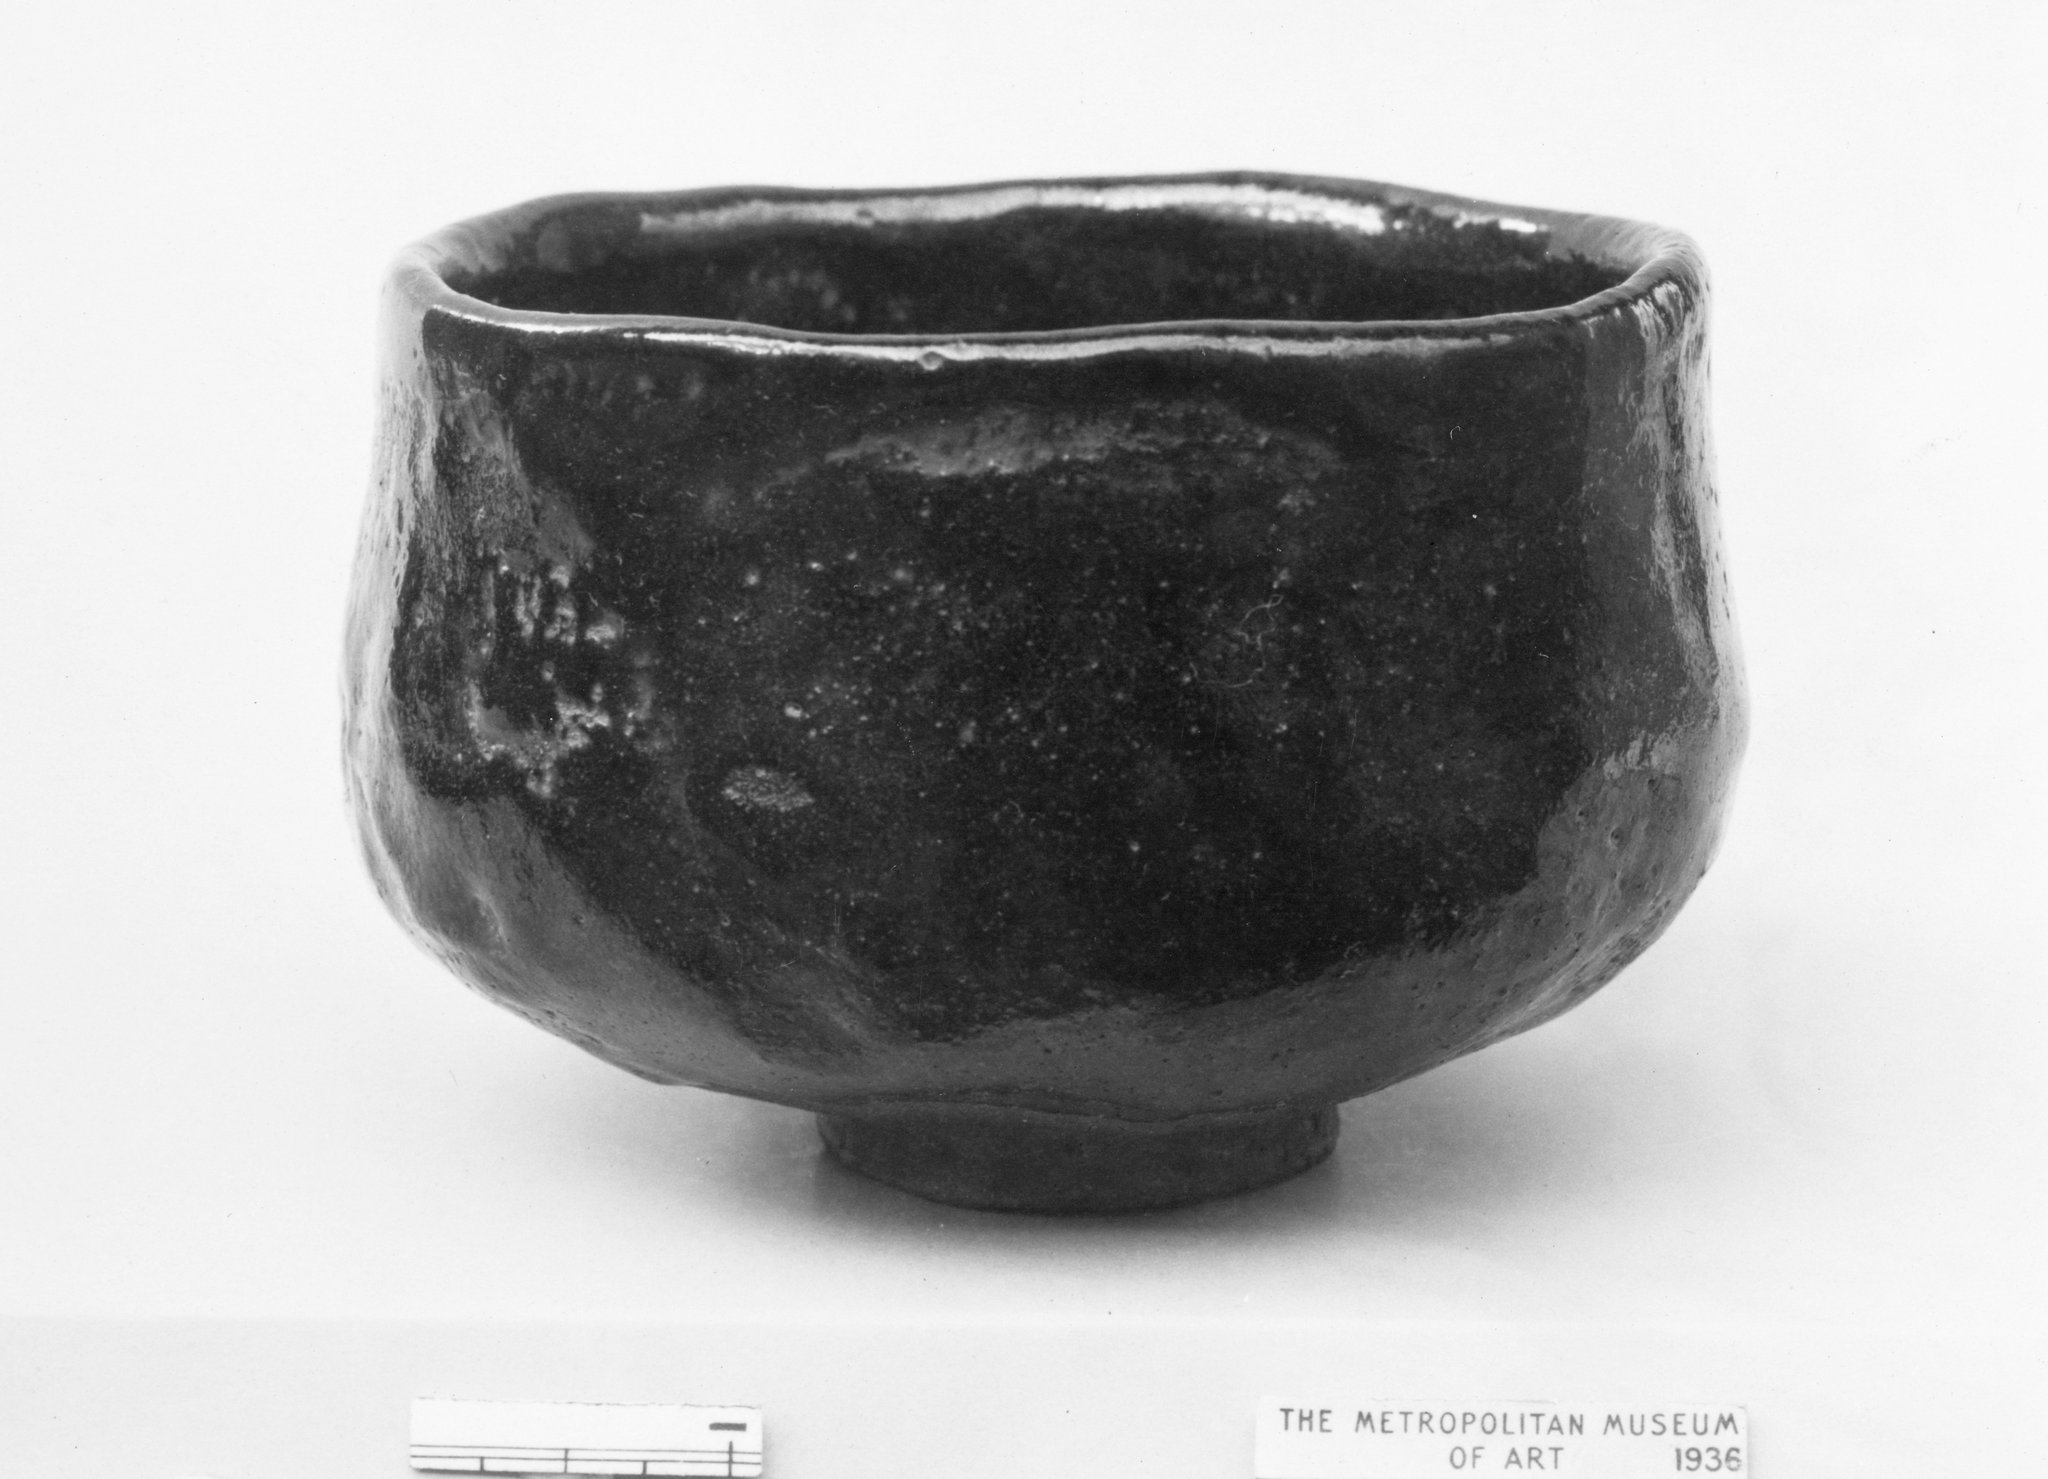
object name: teabowl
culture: japanese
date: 1820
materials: clay, glaze